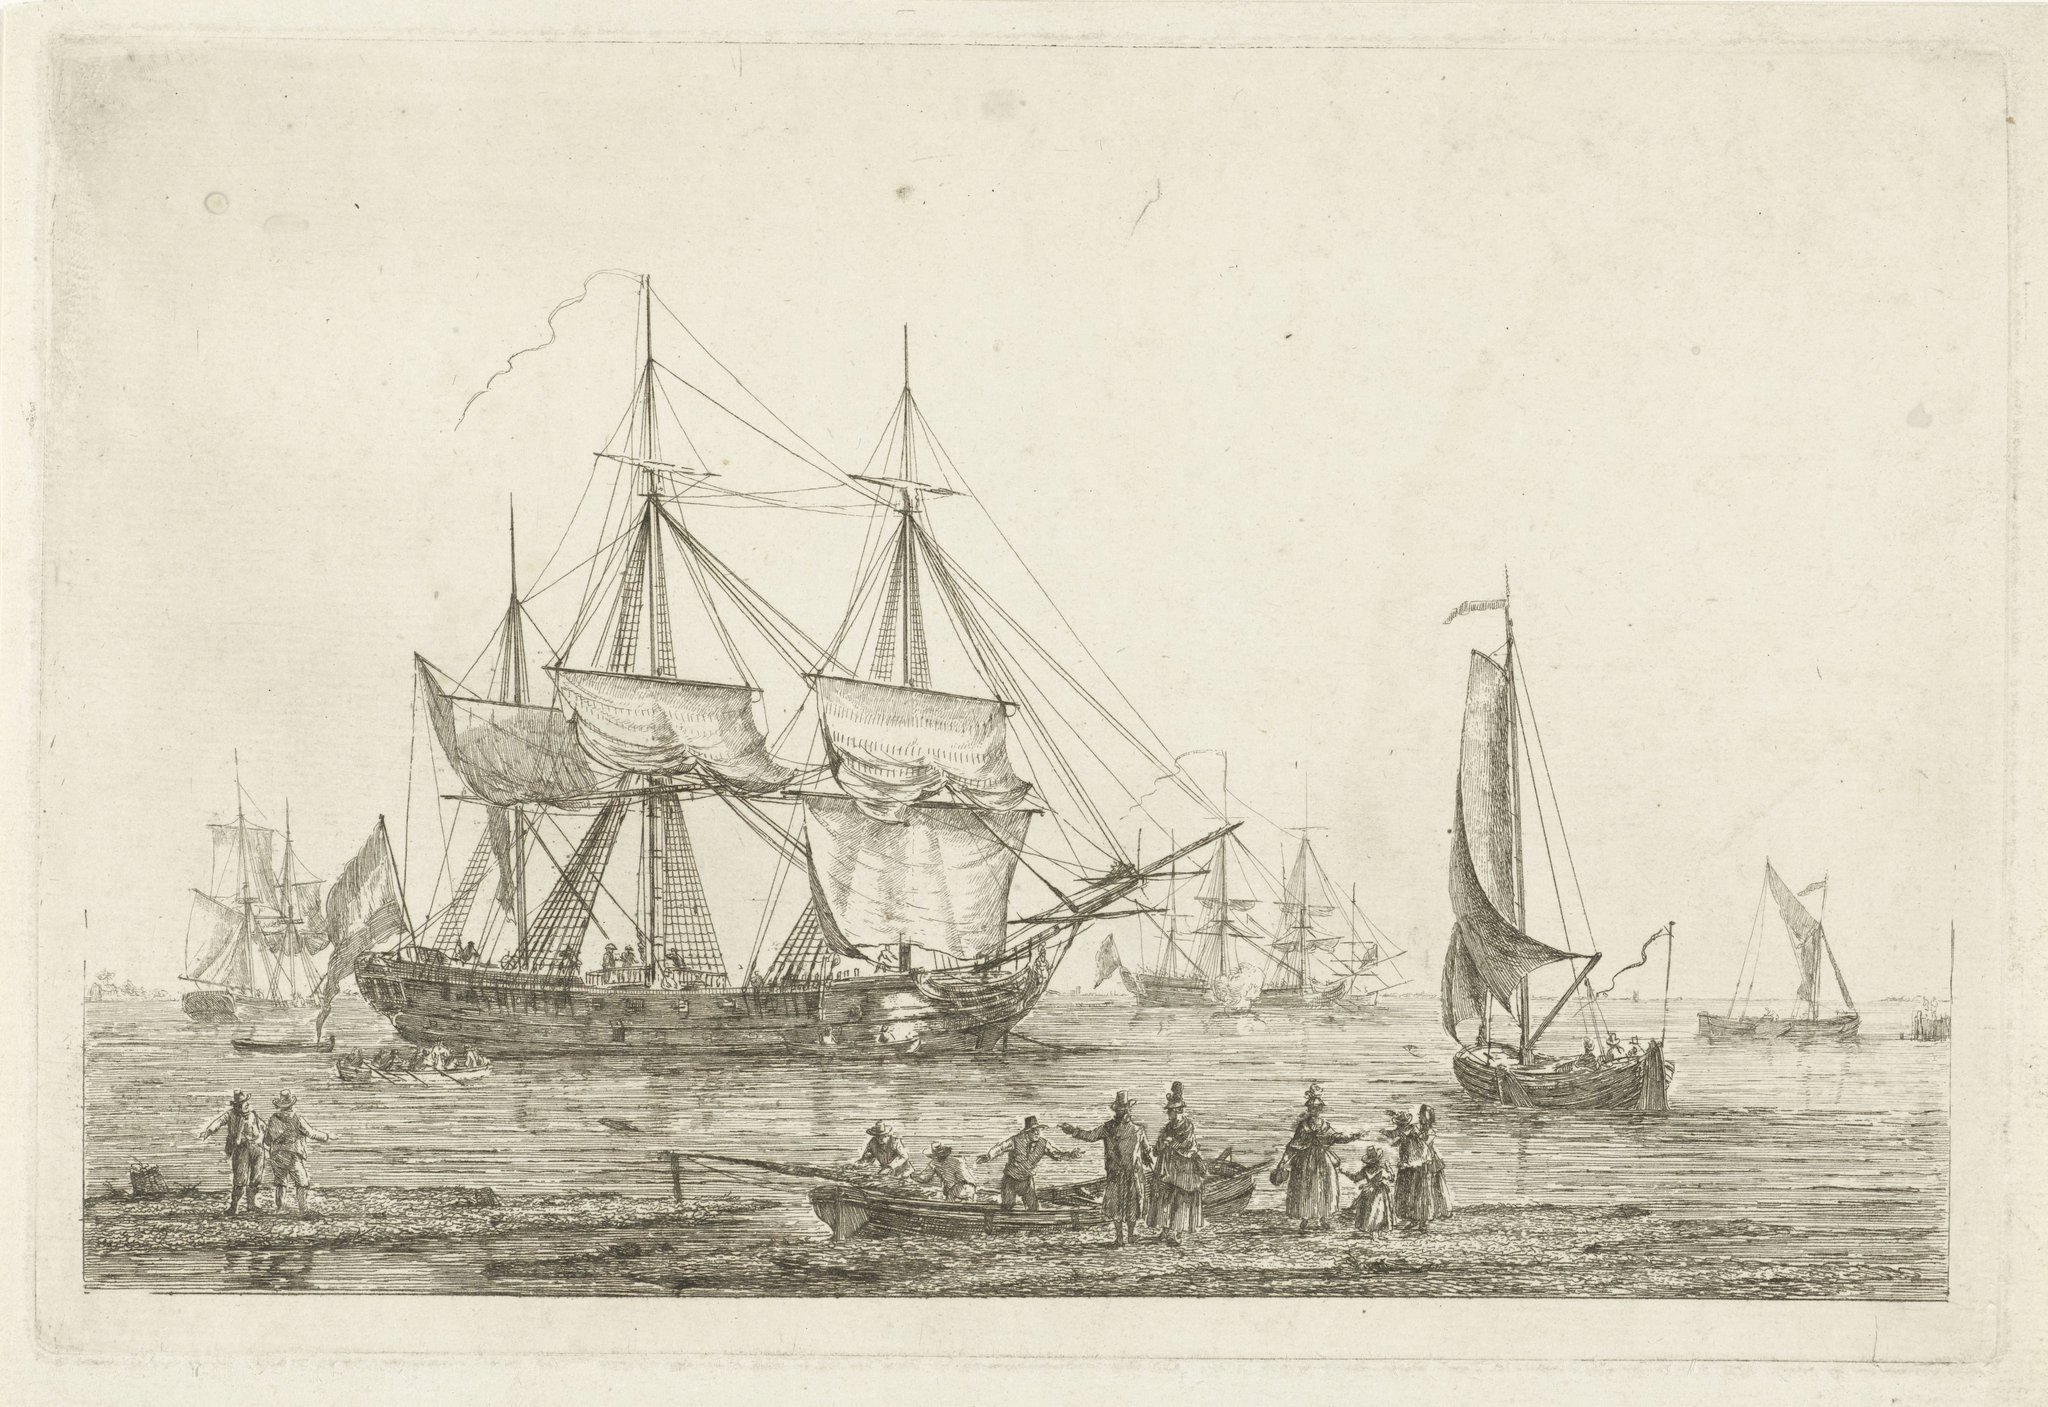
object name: print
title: Twee driemasters en andere schepen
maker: gerrit groenewegen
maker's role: draughtsman, print maker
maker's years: 1754-1826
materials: paper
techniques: printmaking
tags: ships (in general)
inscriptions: collector's mark: Lugt 2228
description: Twee driemasters en andere schepen in de buurt van de wal. Aan wal staan elf figuren, waarvan drie mannen in een sloep zijn afgebeeld. Deze prent maakt deel uit van een serie van vijf prenten met verschillende schepen op open water.